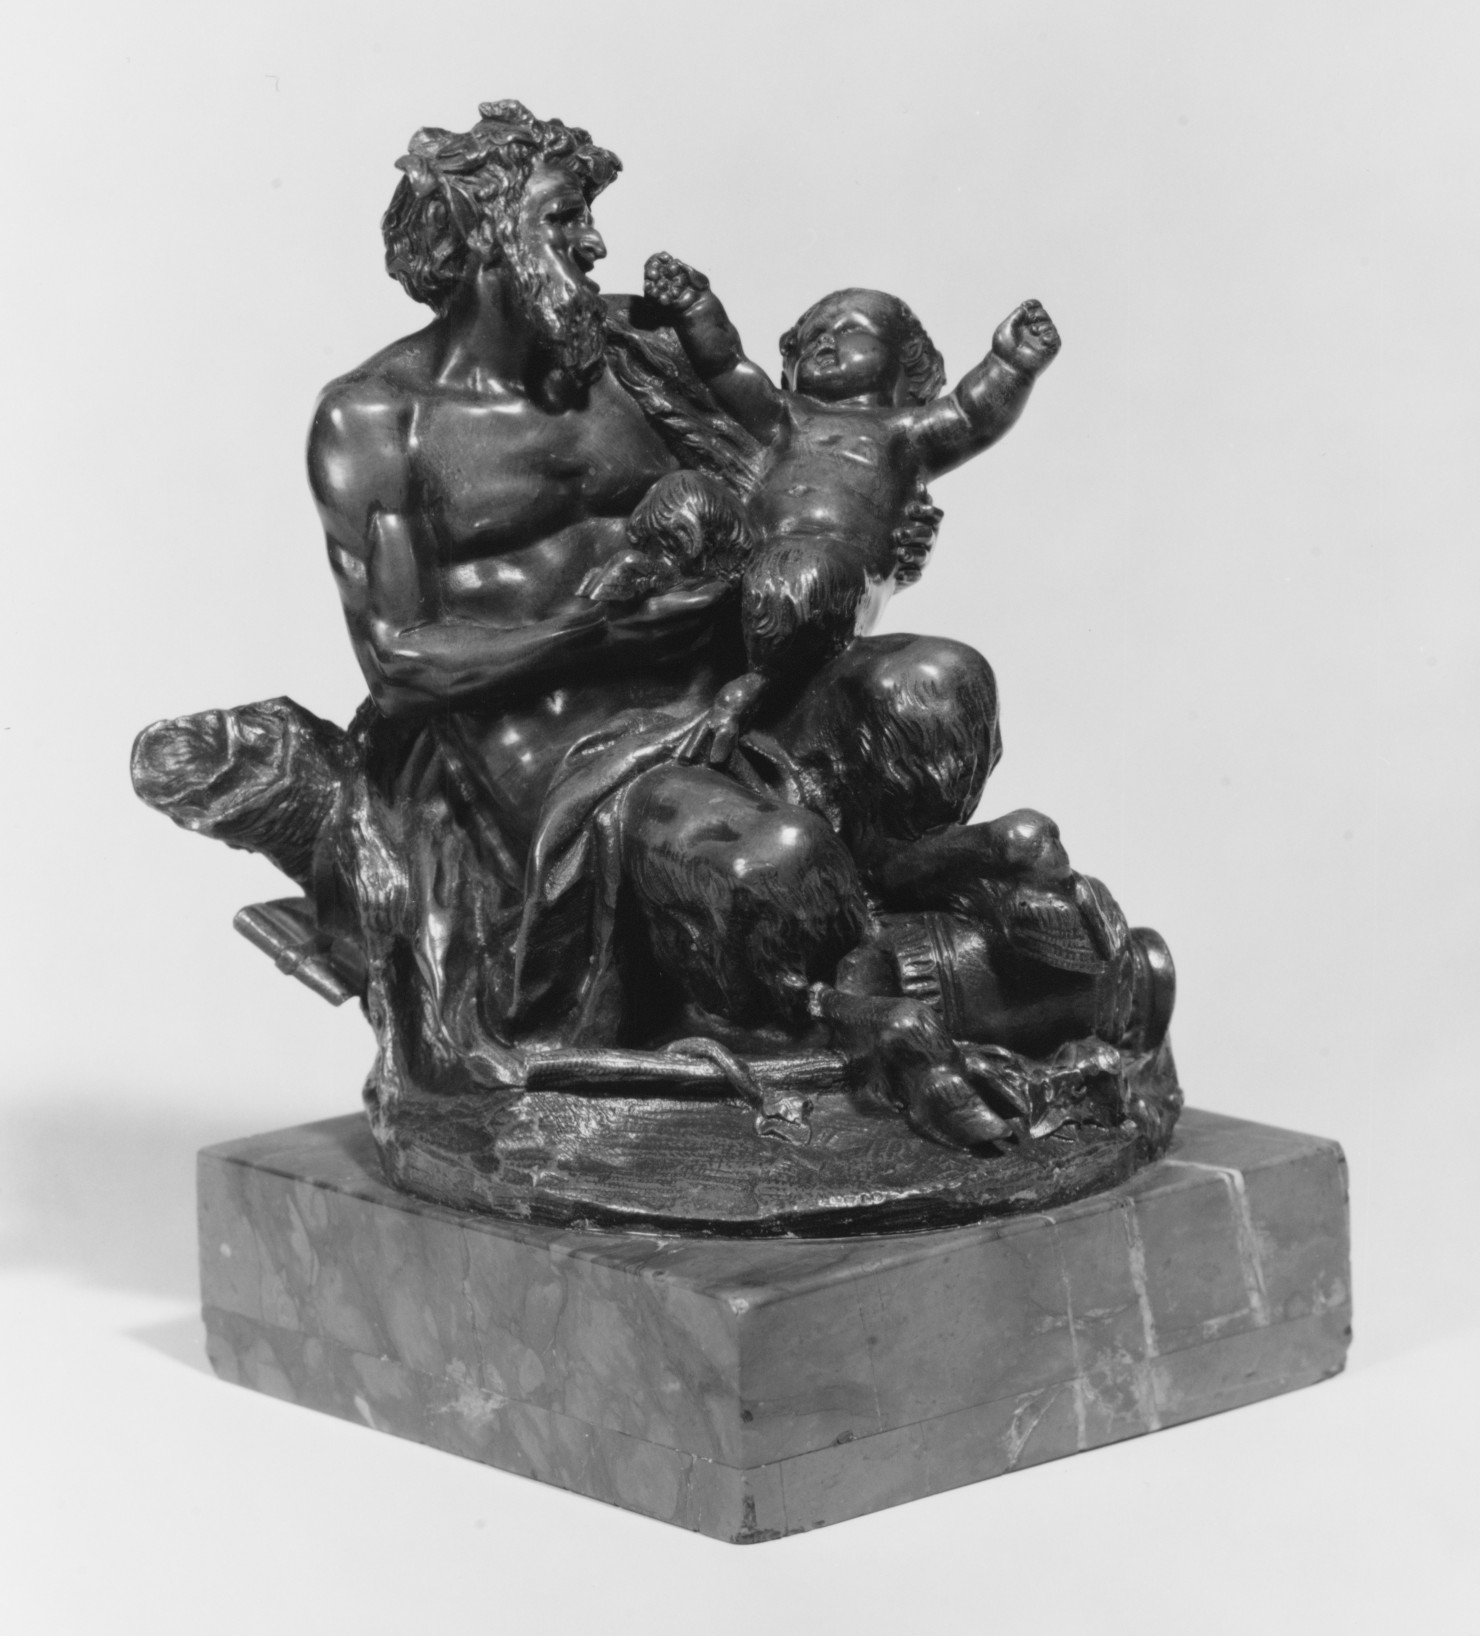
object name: statuette group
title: Satyr Father and Son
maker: joseph-charles marin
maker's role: artist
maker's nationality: french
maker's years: 1759-1834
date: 1701-1900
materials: bronze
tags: infants,fathers,satyrs